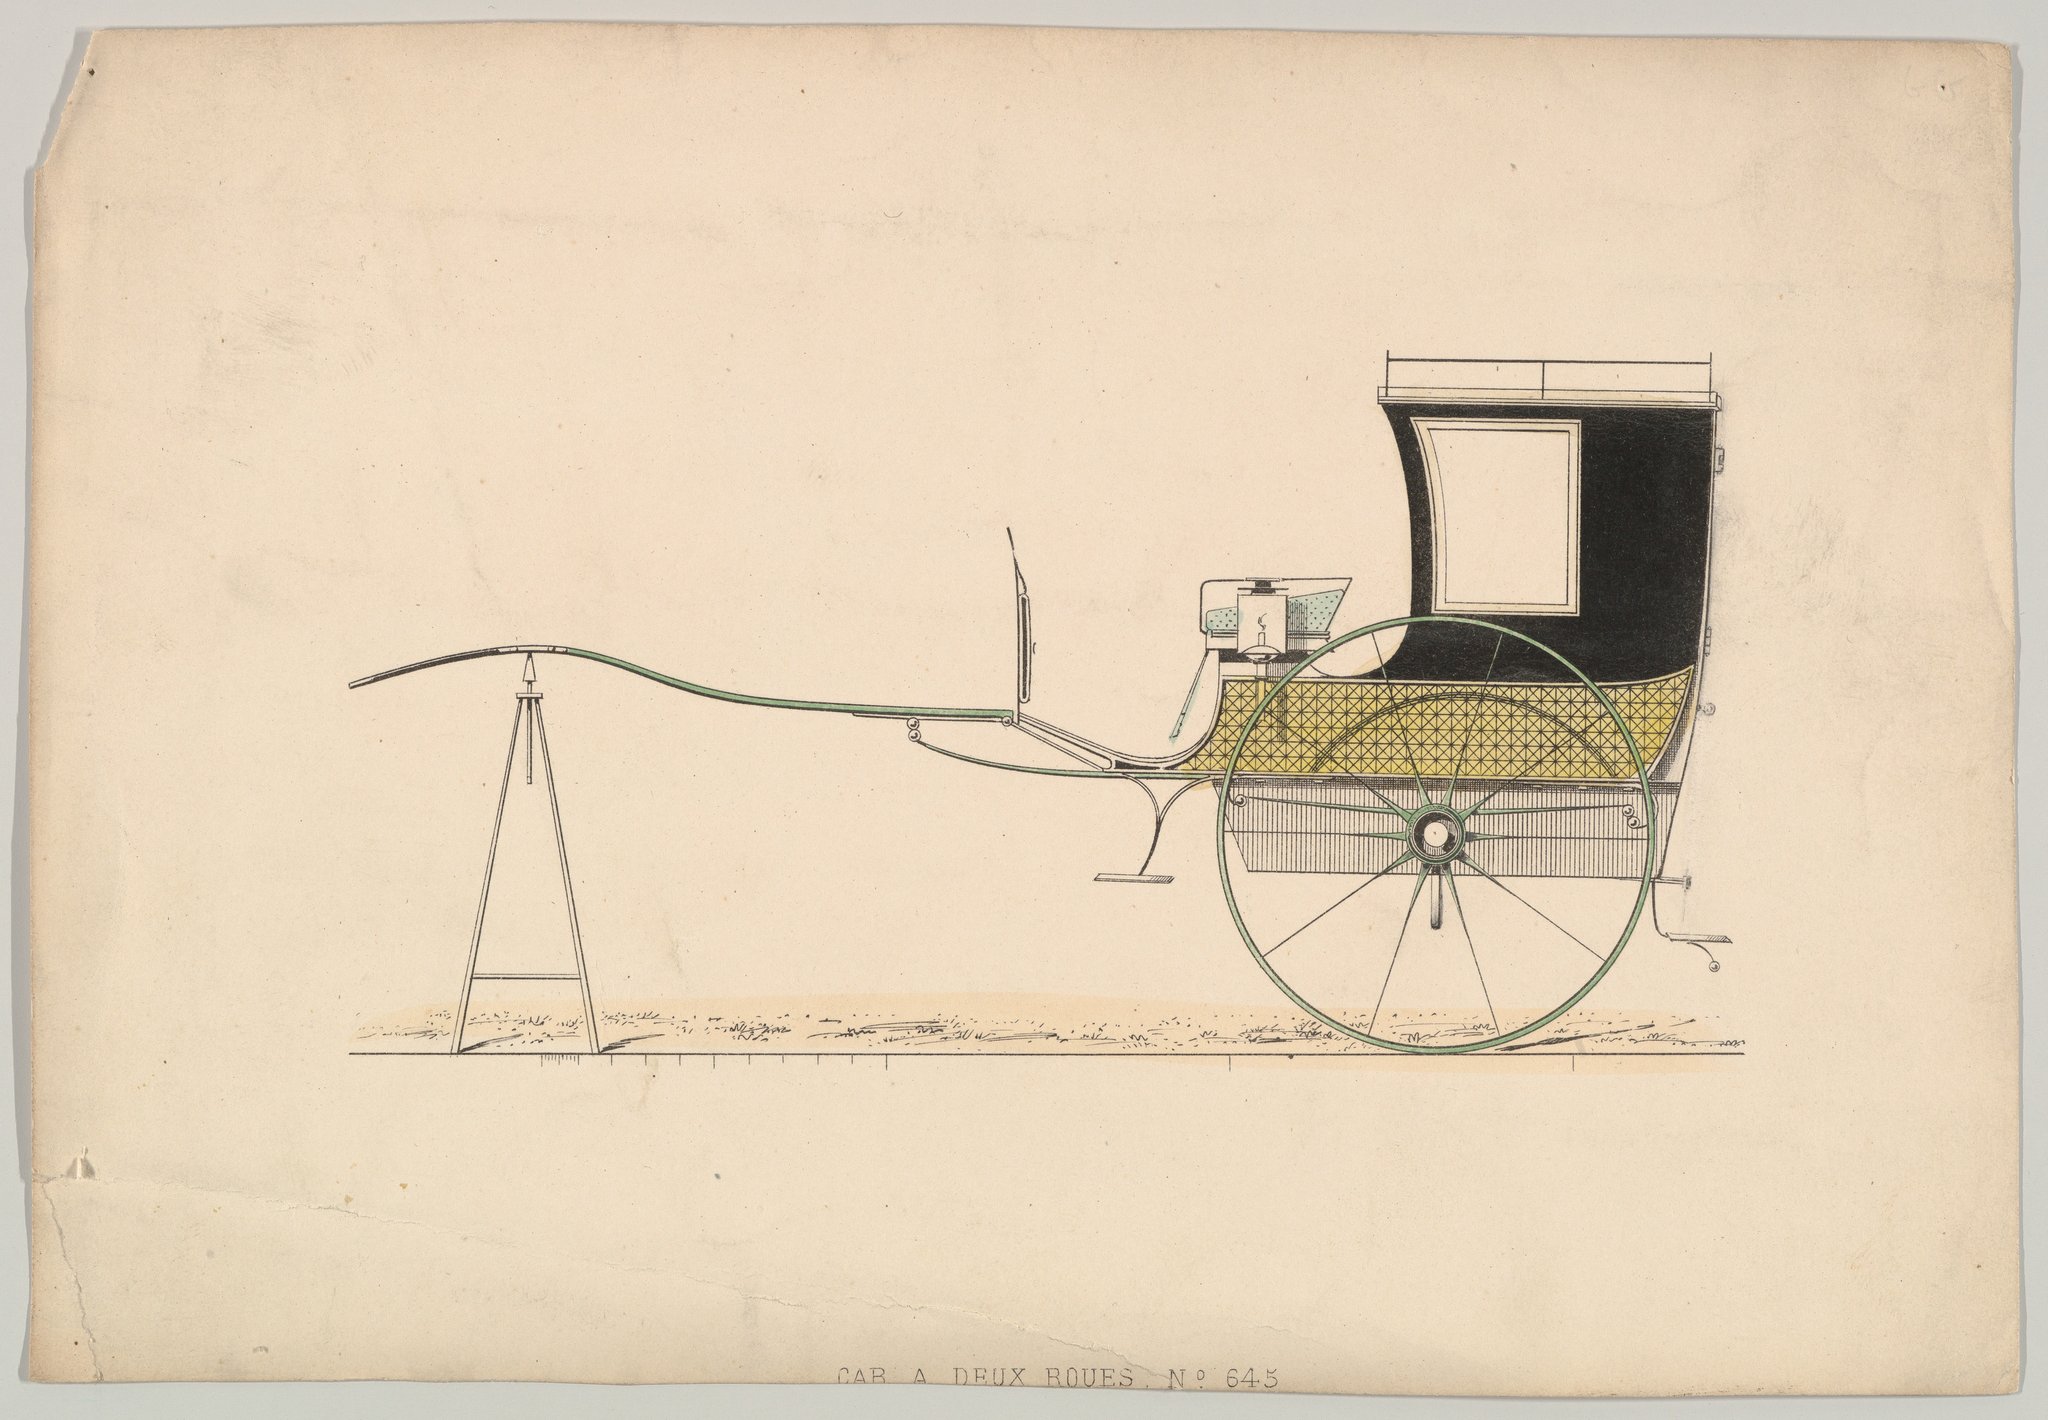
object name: print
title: "Cab à Deux Roues" (Vehicle with two wheels)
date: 1870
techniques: lithograph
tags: carriages